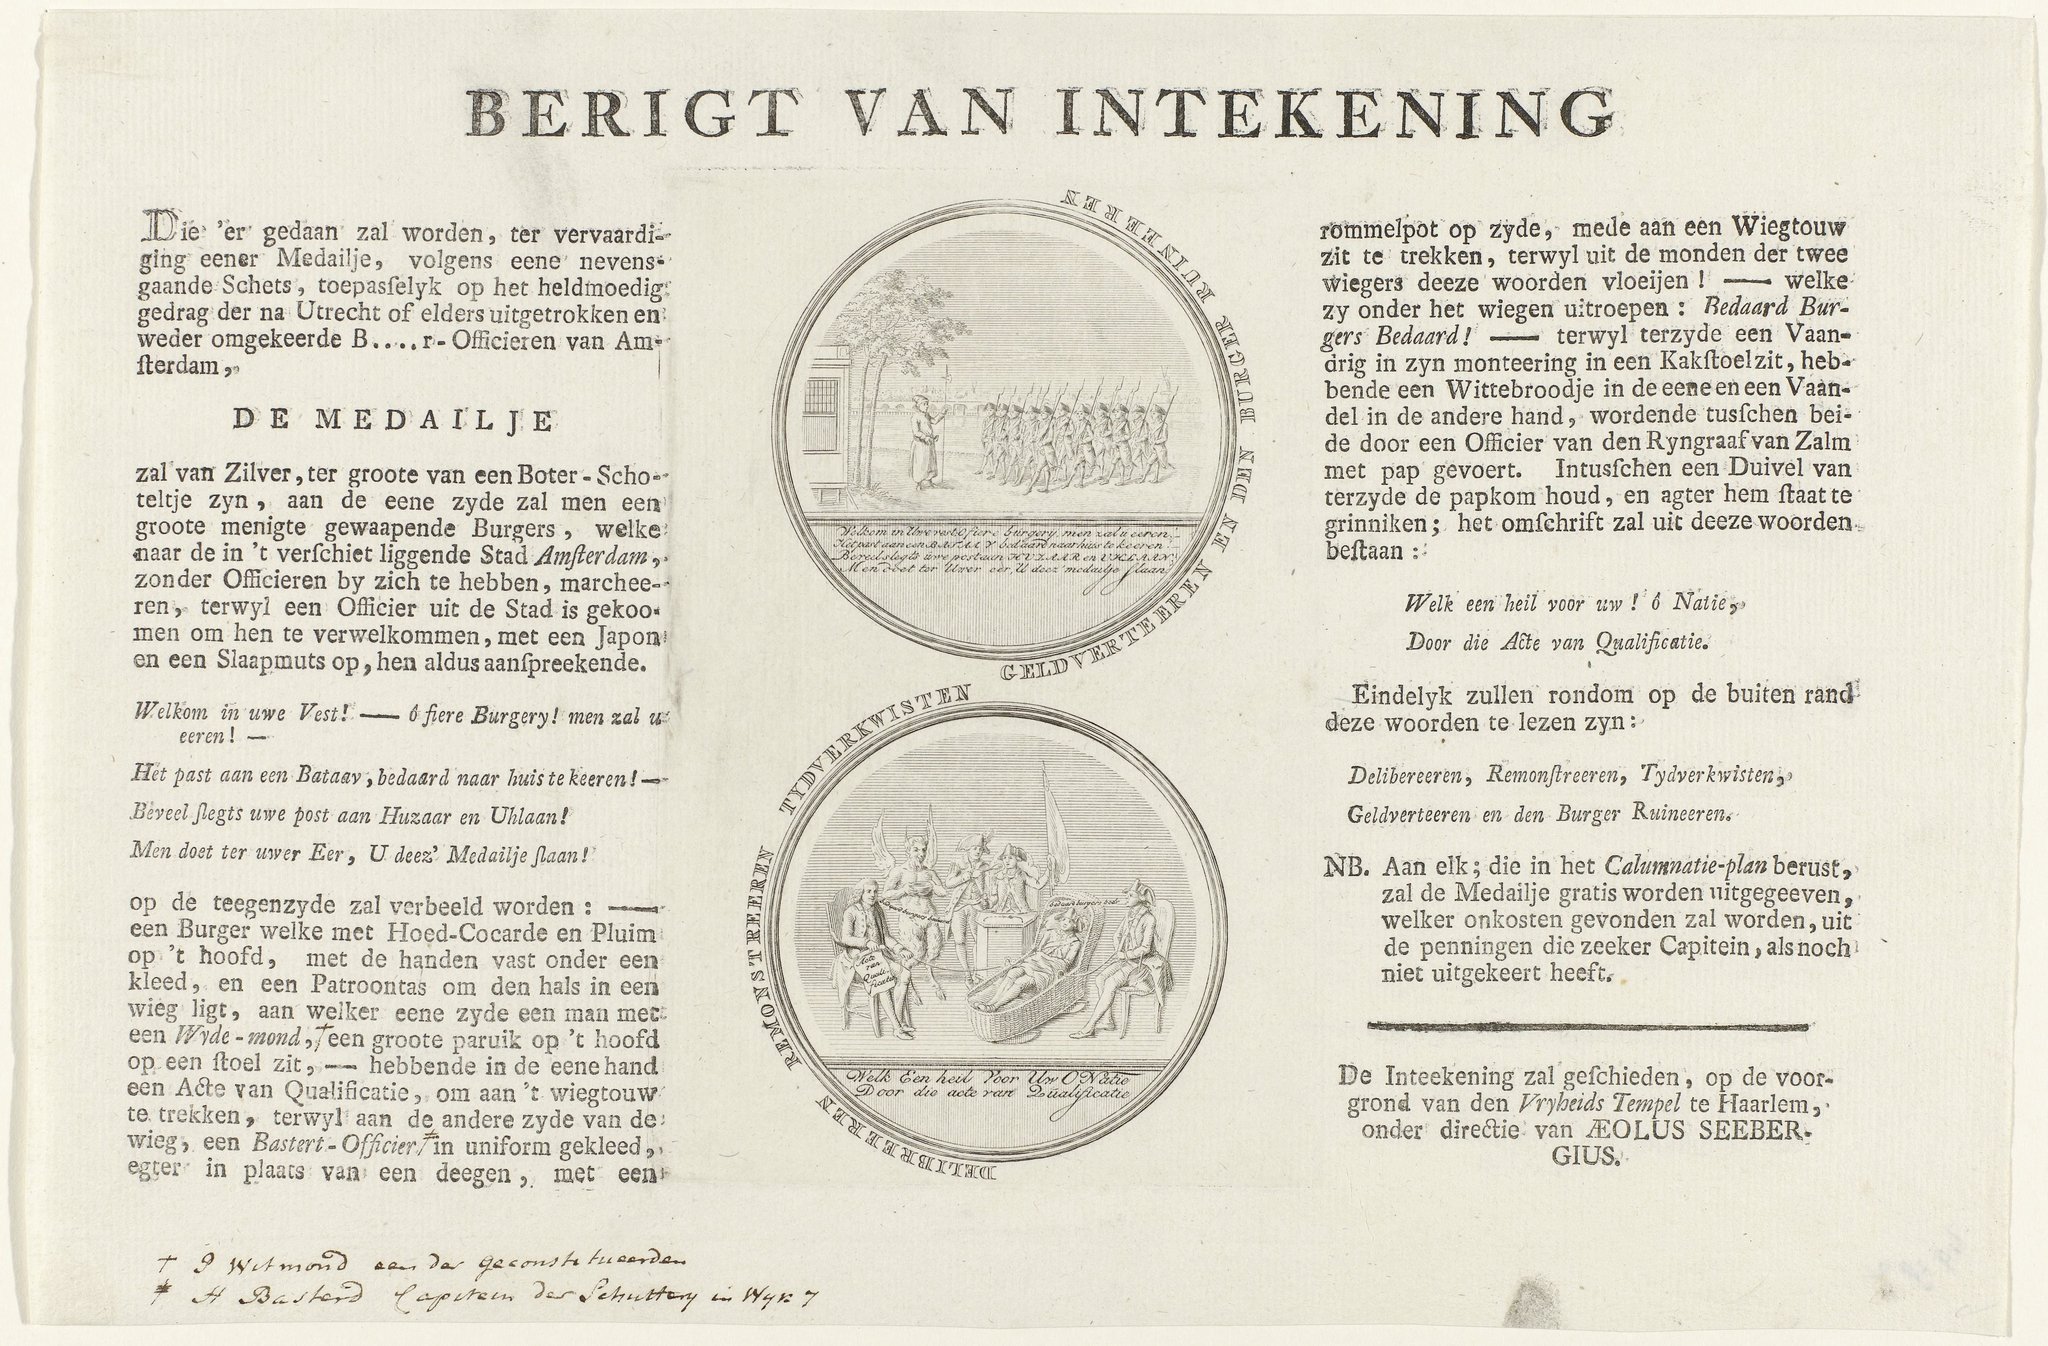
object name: print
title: Berigt van Intekening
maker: Anonymous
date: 1787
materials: paper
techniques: engraving, etching, letterpress printing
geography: northern netherlands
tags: medal (considered as a piece of sculpture, regardless of its specific function)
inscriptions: collector's mark: Lugt 2228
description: Spotprent in de vorm van een bericht van intekening op een (niet-bestaande) medaille ter ere van de terugkeer van de Amsterdamse patriotten uit Utrecht, 1787. Op de voorzijde worden de gewapende burgers verwelkomd bij herberg de Berebijt door een man in kamerjas en slaapmuts. Op de keerzijde wordt een gewapende burger gewiegd door P. Witmond. Aan weerszijden van de plaat een gedrukte beschrijving van de voorstellingen.